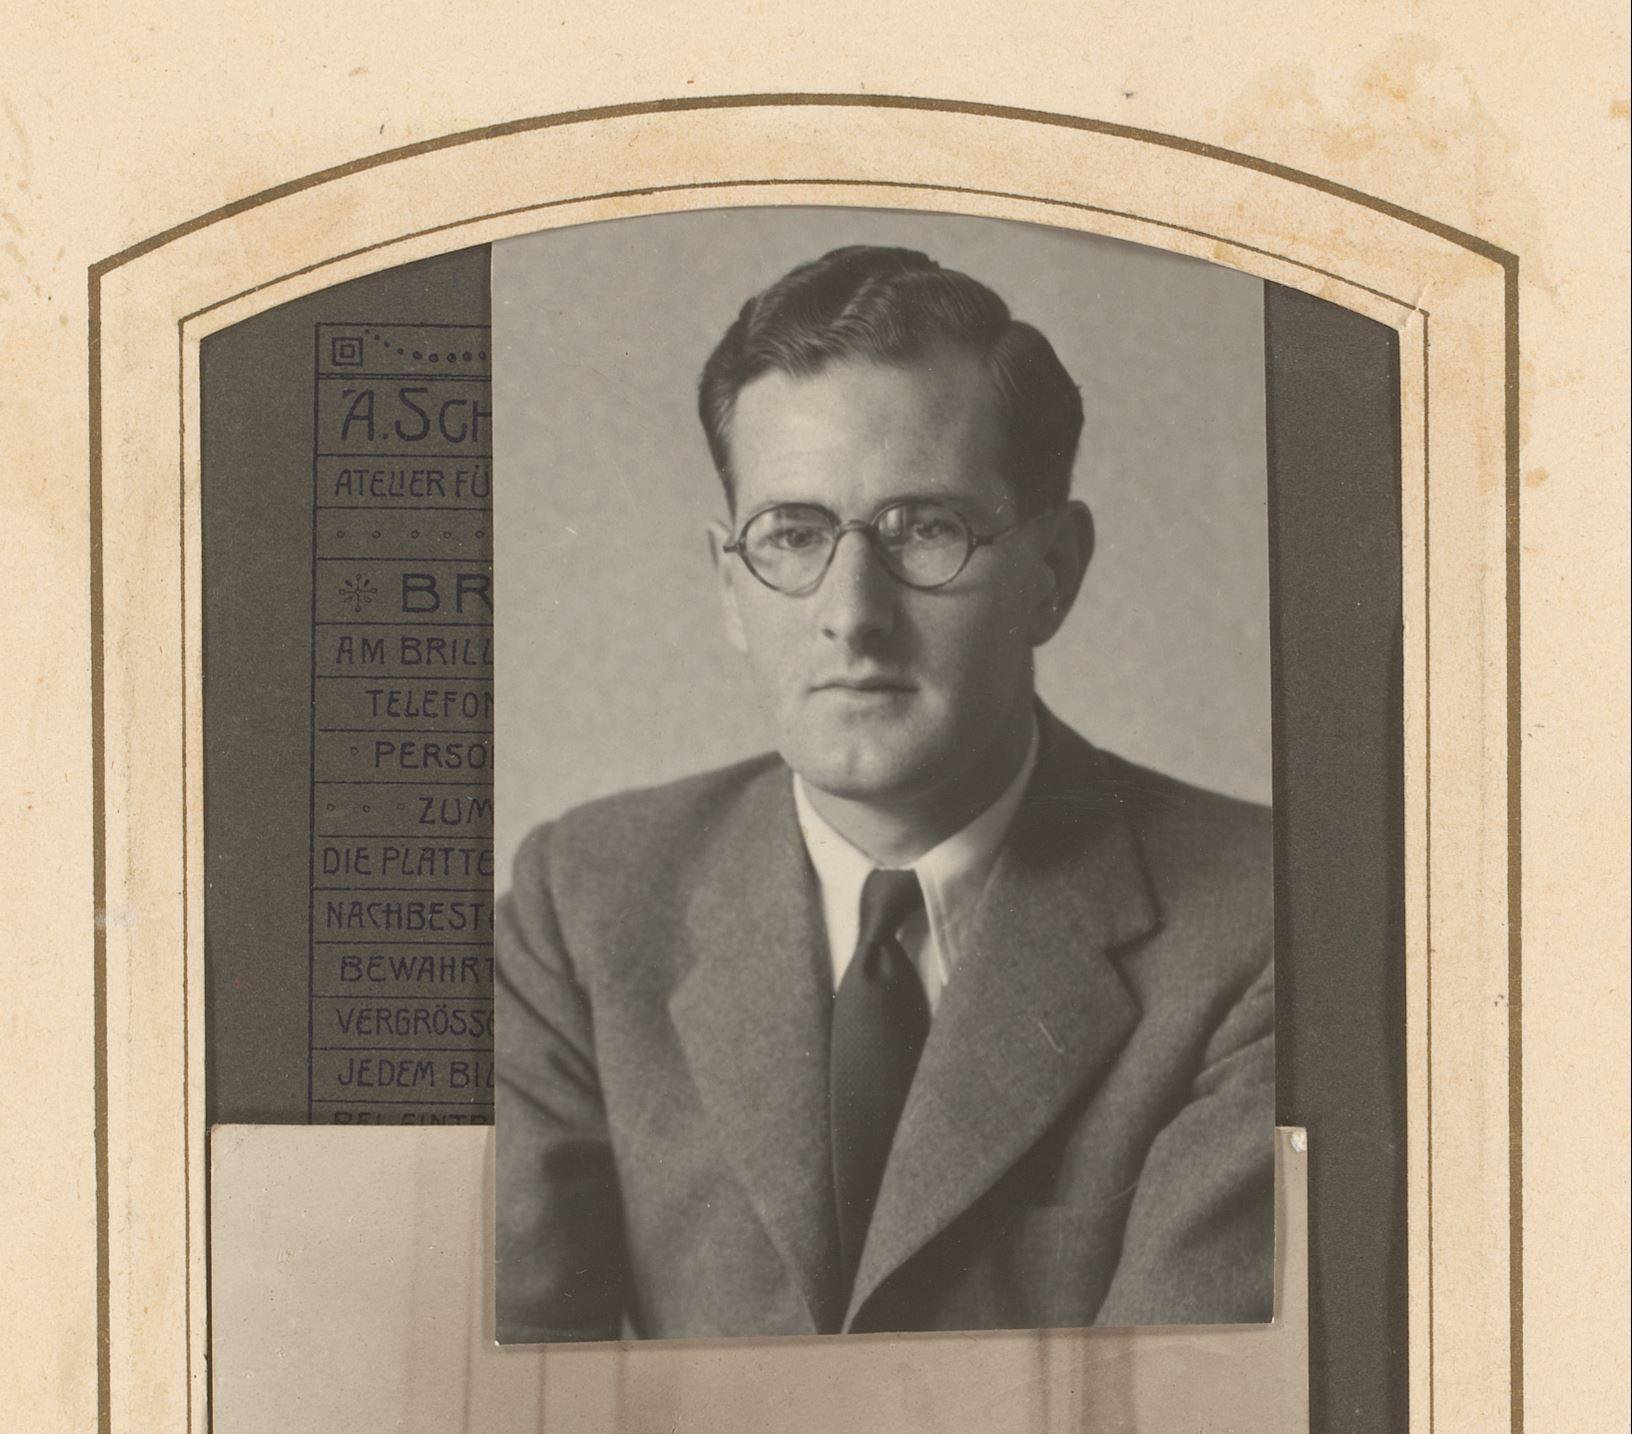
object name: photograph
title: Portret van een man met bril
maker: Anonymous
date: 1905-1936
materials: cardboard, photographic support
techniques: gelatin silver print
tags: eyeglasses, spectacles, adult man, historical persons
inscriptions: inscription: ‘POST CARD/ CARTE POSTALE/ Communication-Correspondance Address - Adresse’